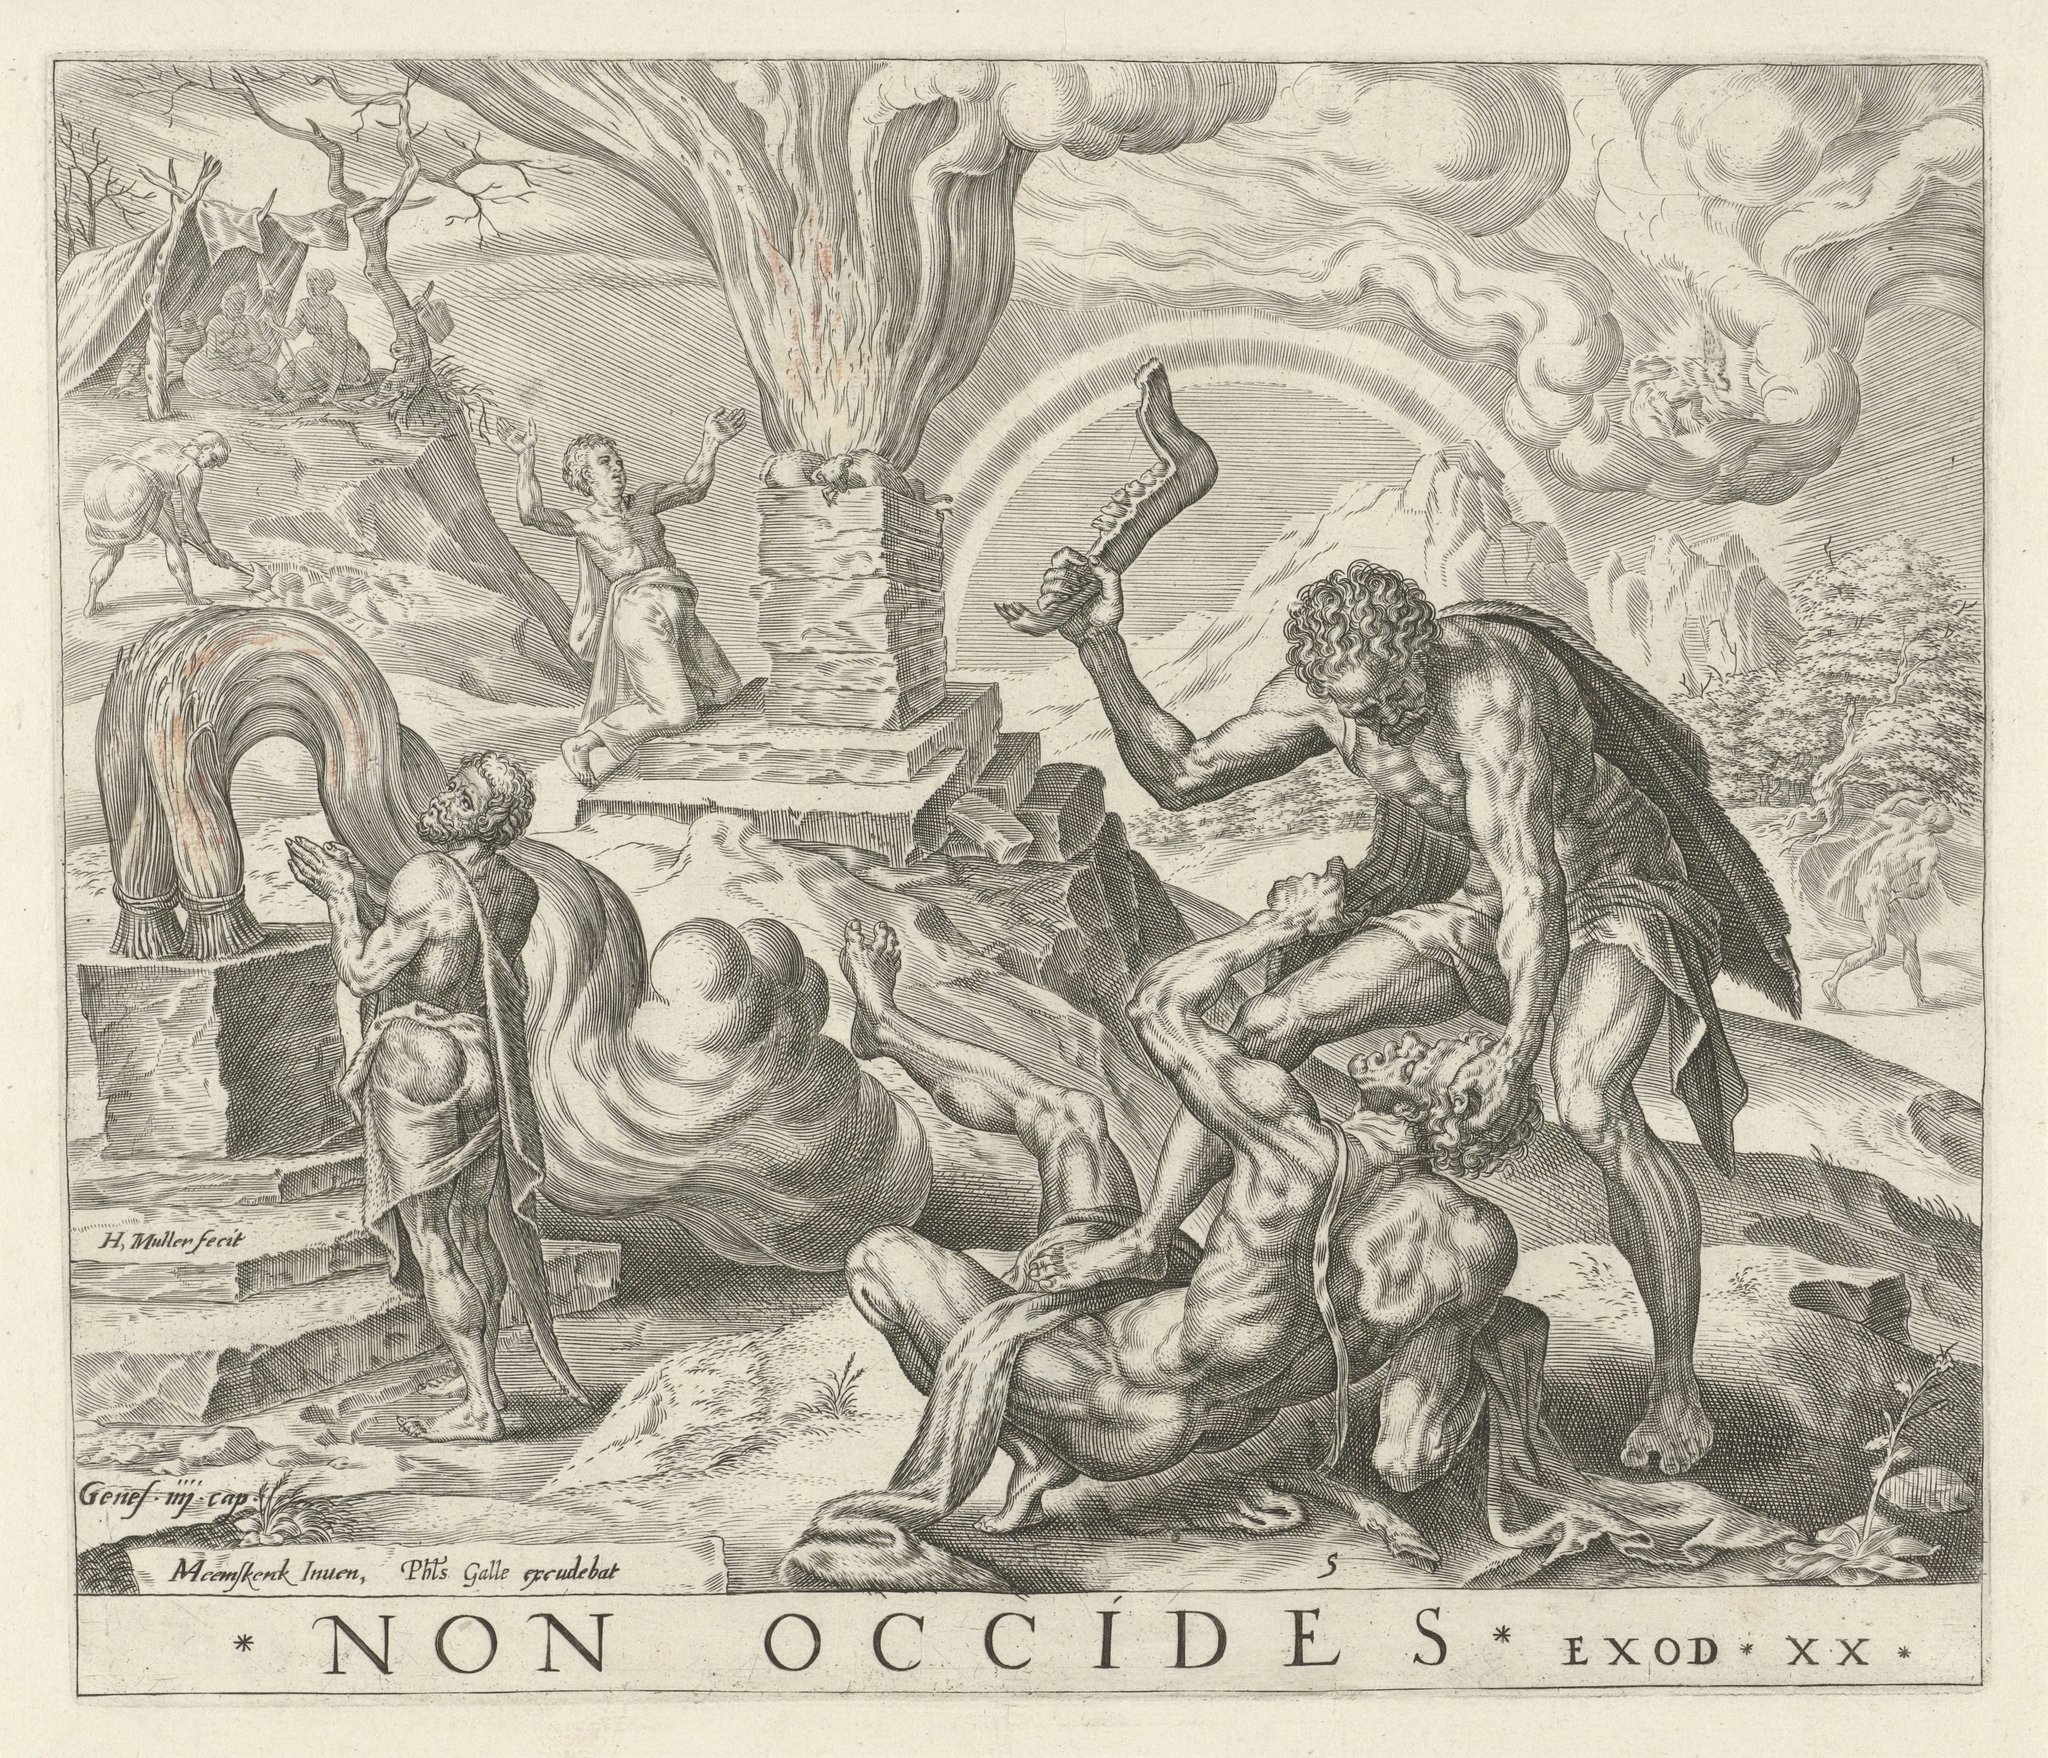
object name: print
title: De tien geboden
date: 1570-1612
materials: paper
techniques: engraving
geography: amsterdam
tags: the killing of abel: cain slays him with a stone, a club or a jaw-bone, alternatively with a spade or another tool as weapon, 'you shall not kill' ~ separate representation of the sixth of the ten commandments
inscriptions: collector's mark: Lugt 2228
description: Kaïn slaat zijn broer Abel dood. Op de achtergrond zijn twee offeraltaren te zien. Kaïns offer wordt geweigerd, de rook gaat naar beneden. Het offer van Abel wordt wel door God geaccepteerd. Rechtsachter verschijnt God na de moord aan Kaïn. Prent maakt deel uit van een serie over de tien geboden en geeft een overtreding van het vijfde gebod weer: Gij zult niet doodslaan. Onderaan in de marge een verwijzing naar de Bijbeltekst in het Latijn.